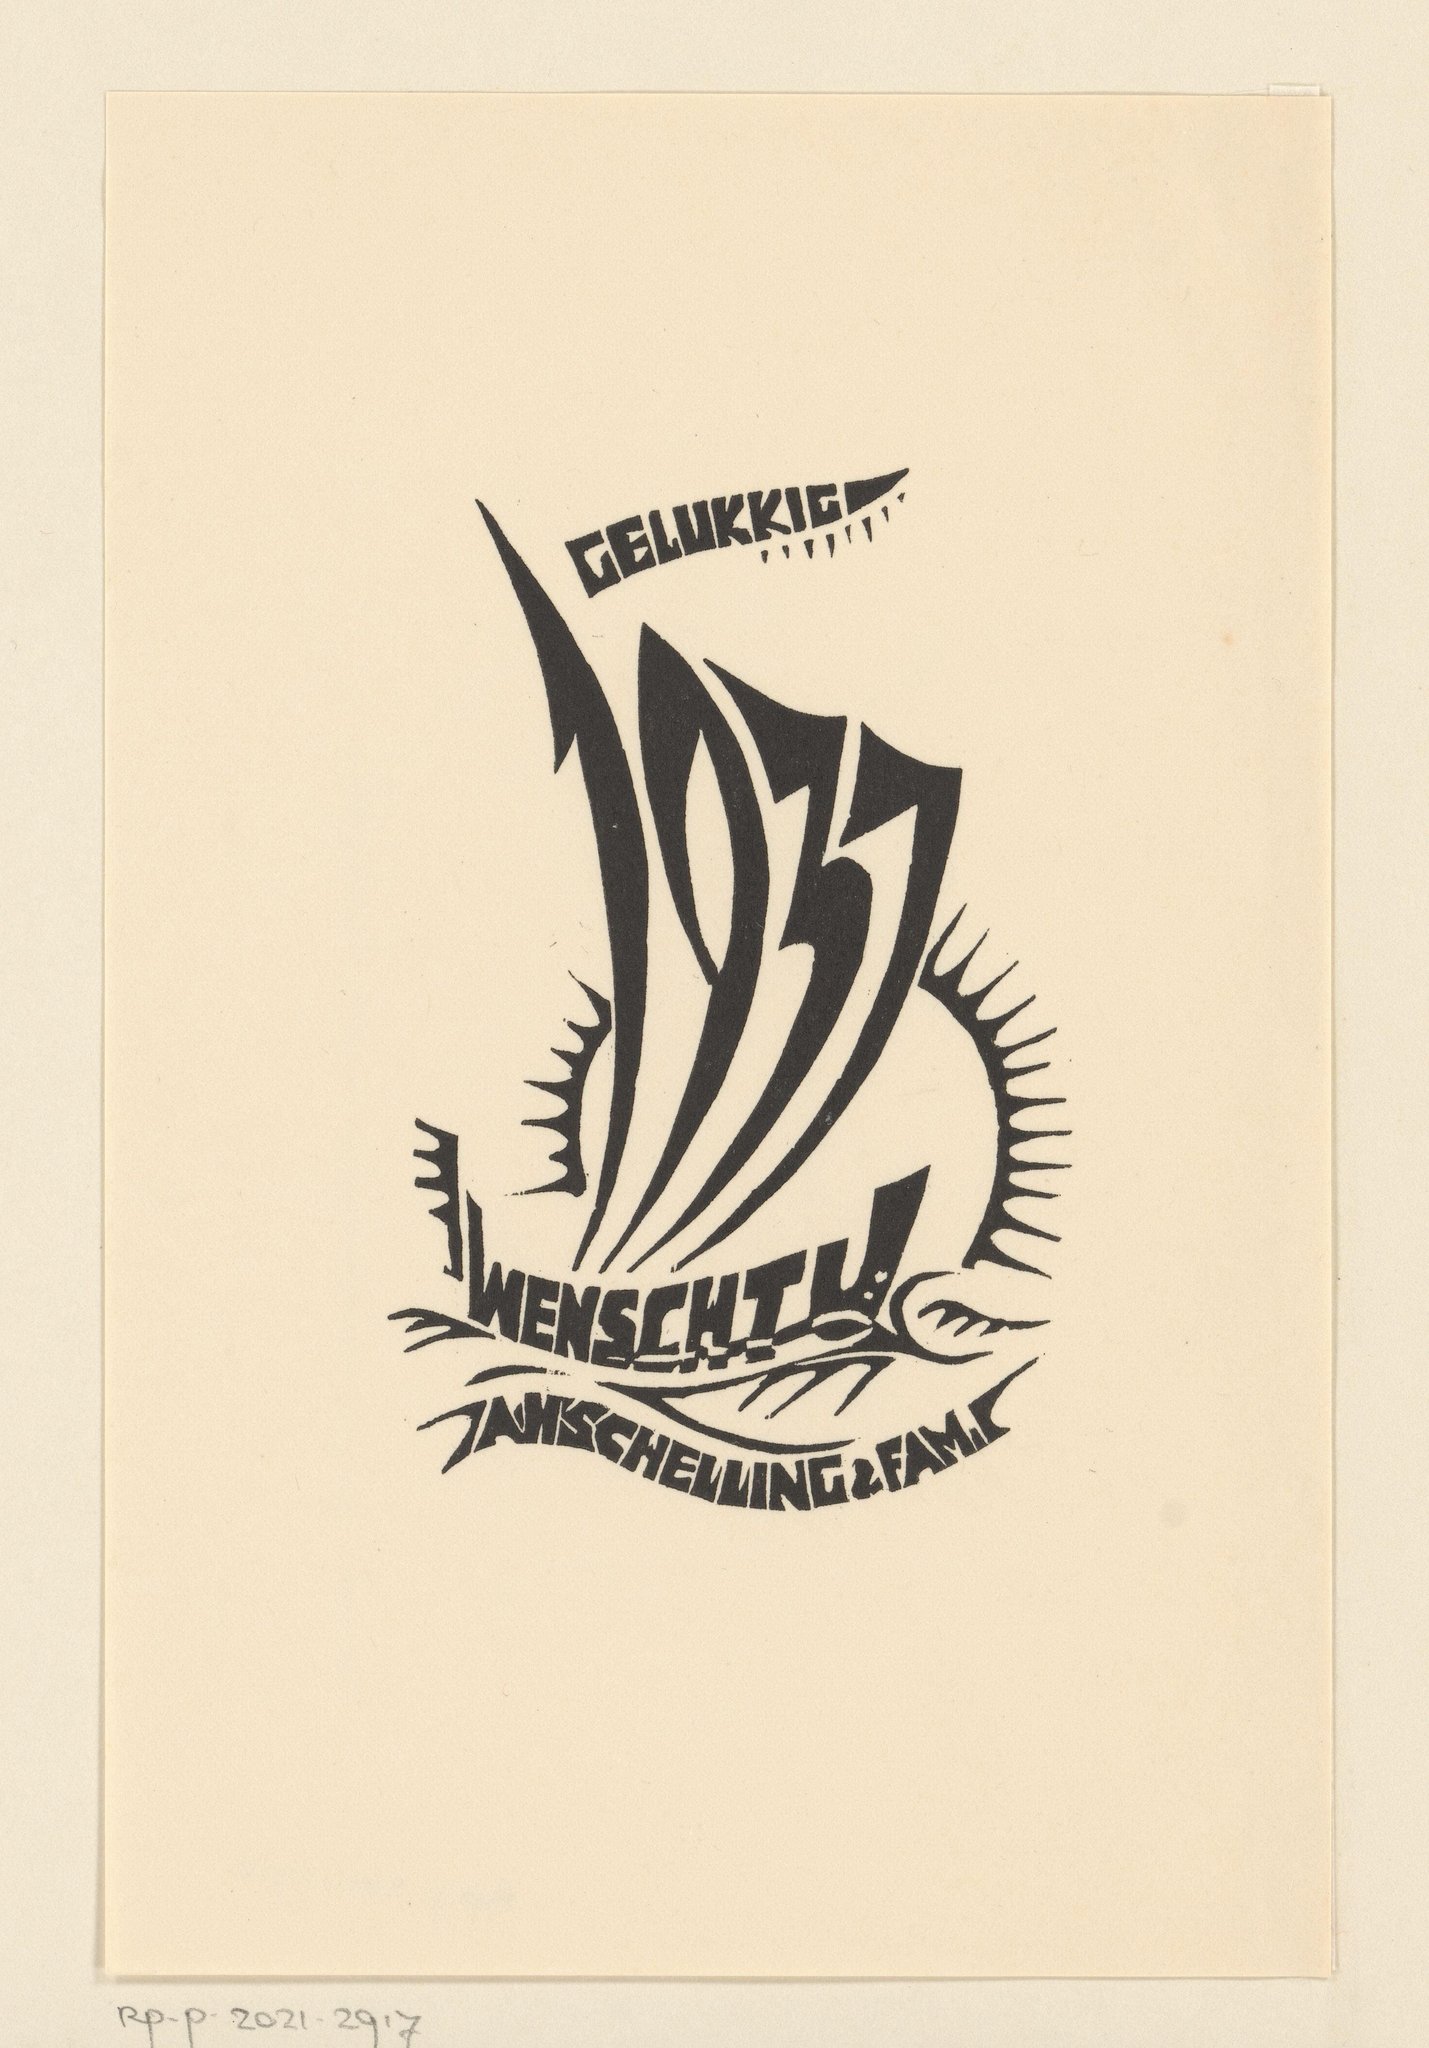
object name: print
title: Nieuwjaarswens voor 1937 van Ir. A.H. Schelling en familie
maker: adrianus hermanus schelling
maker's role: artist, engineer, print maker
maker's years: 1887-1945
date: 1936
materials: paper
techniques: woodcut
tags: print maker, artist, engineer, adrianus hermanus schelling, new year's eve (december 31), fancy letters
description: Voor een zon het jaartal 1937. Daarbij de tekst: 'Gelukkig 1937 wenscht U A.H. Schelling & Fam.'